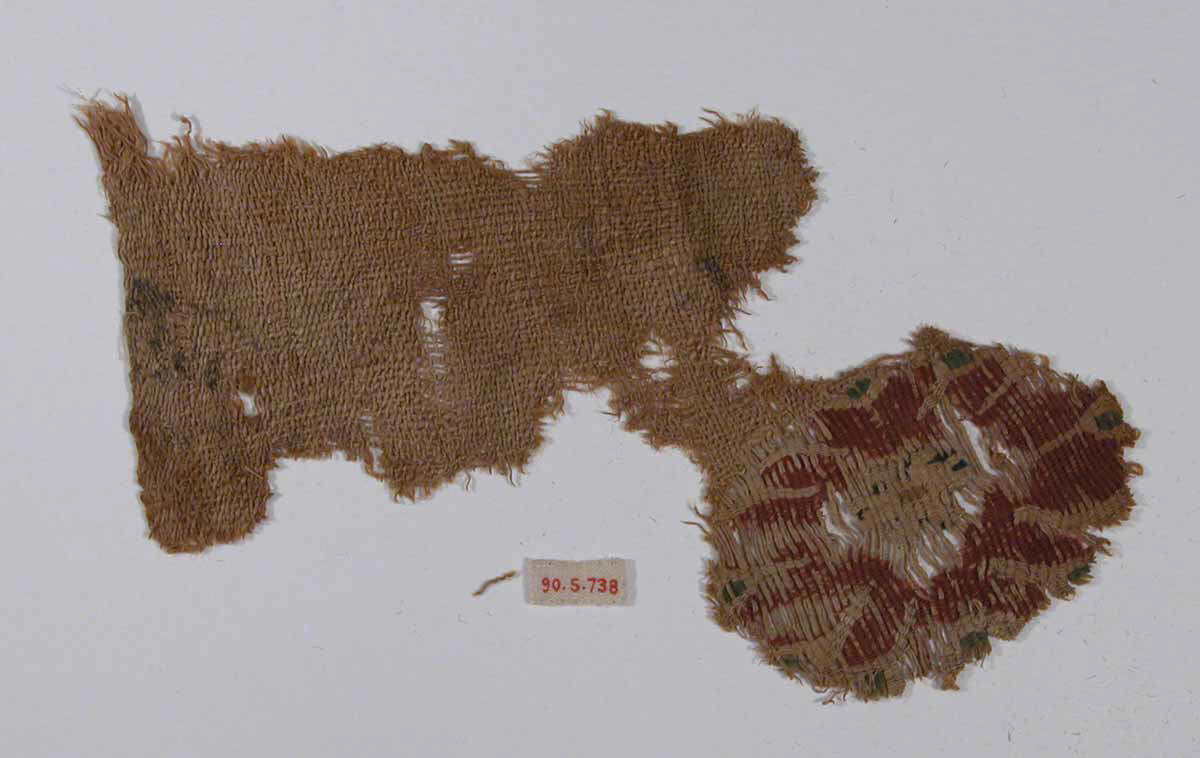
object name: textile fragment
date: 401-600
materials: linen, wool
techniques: weave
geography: egypt